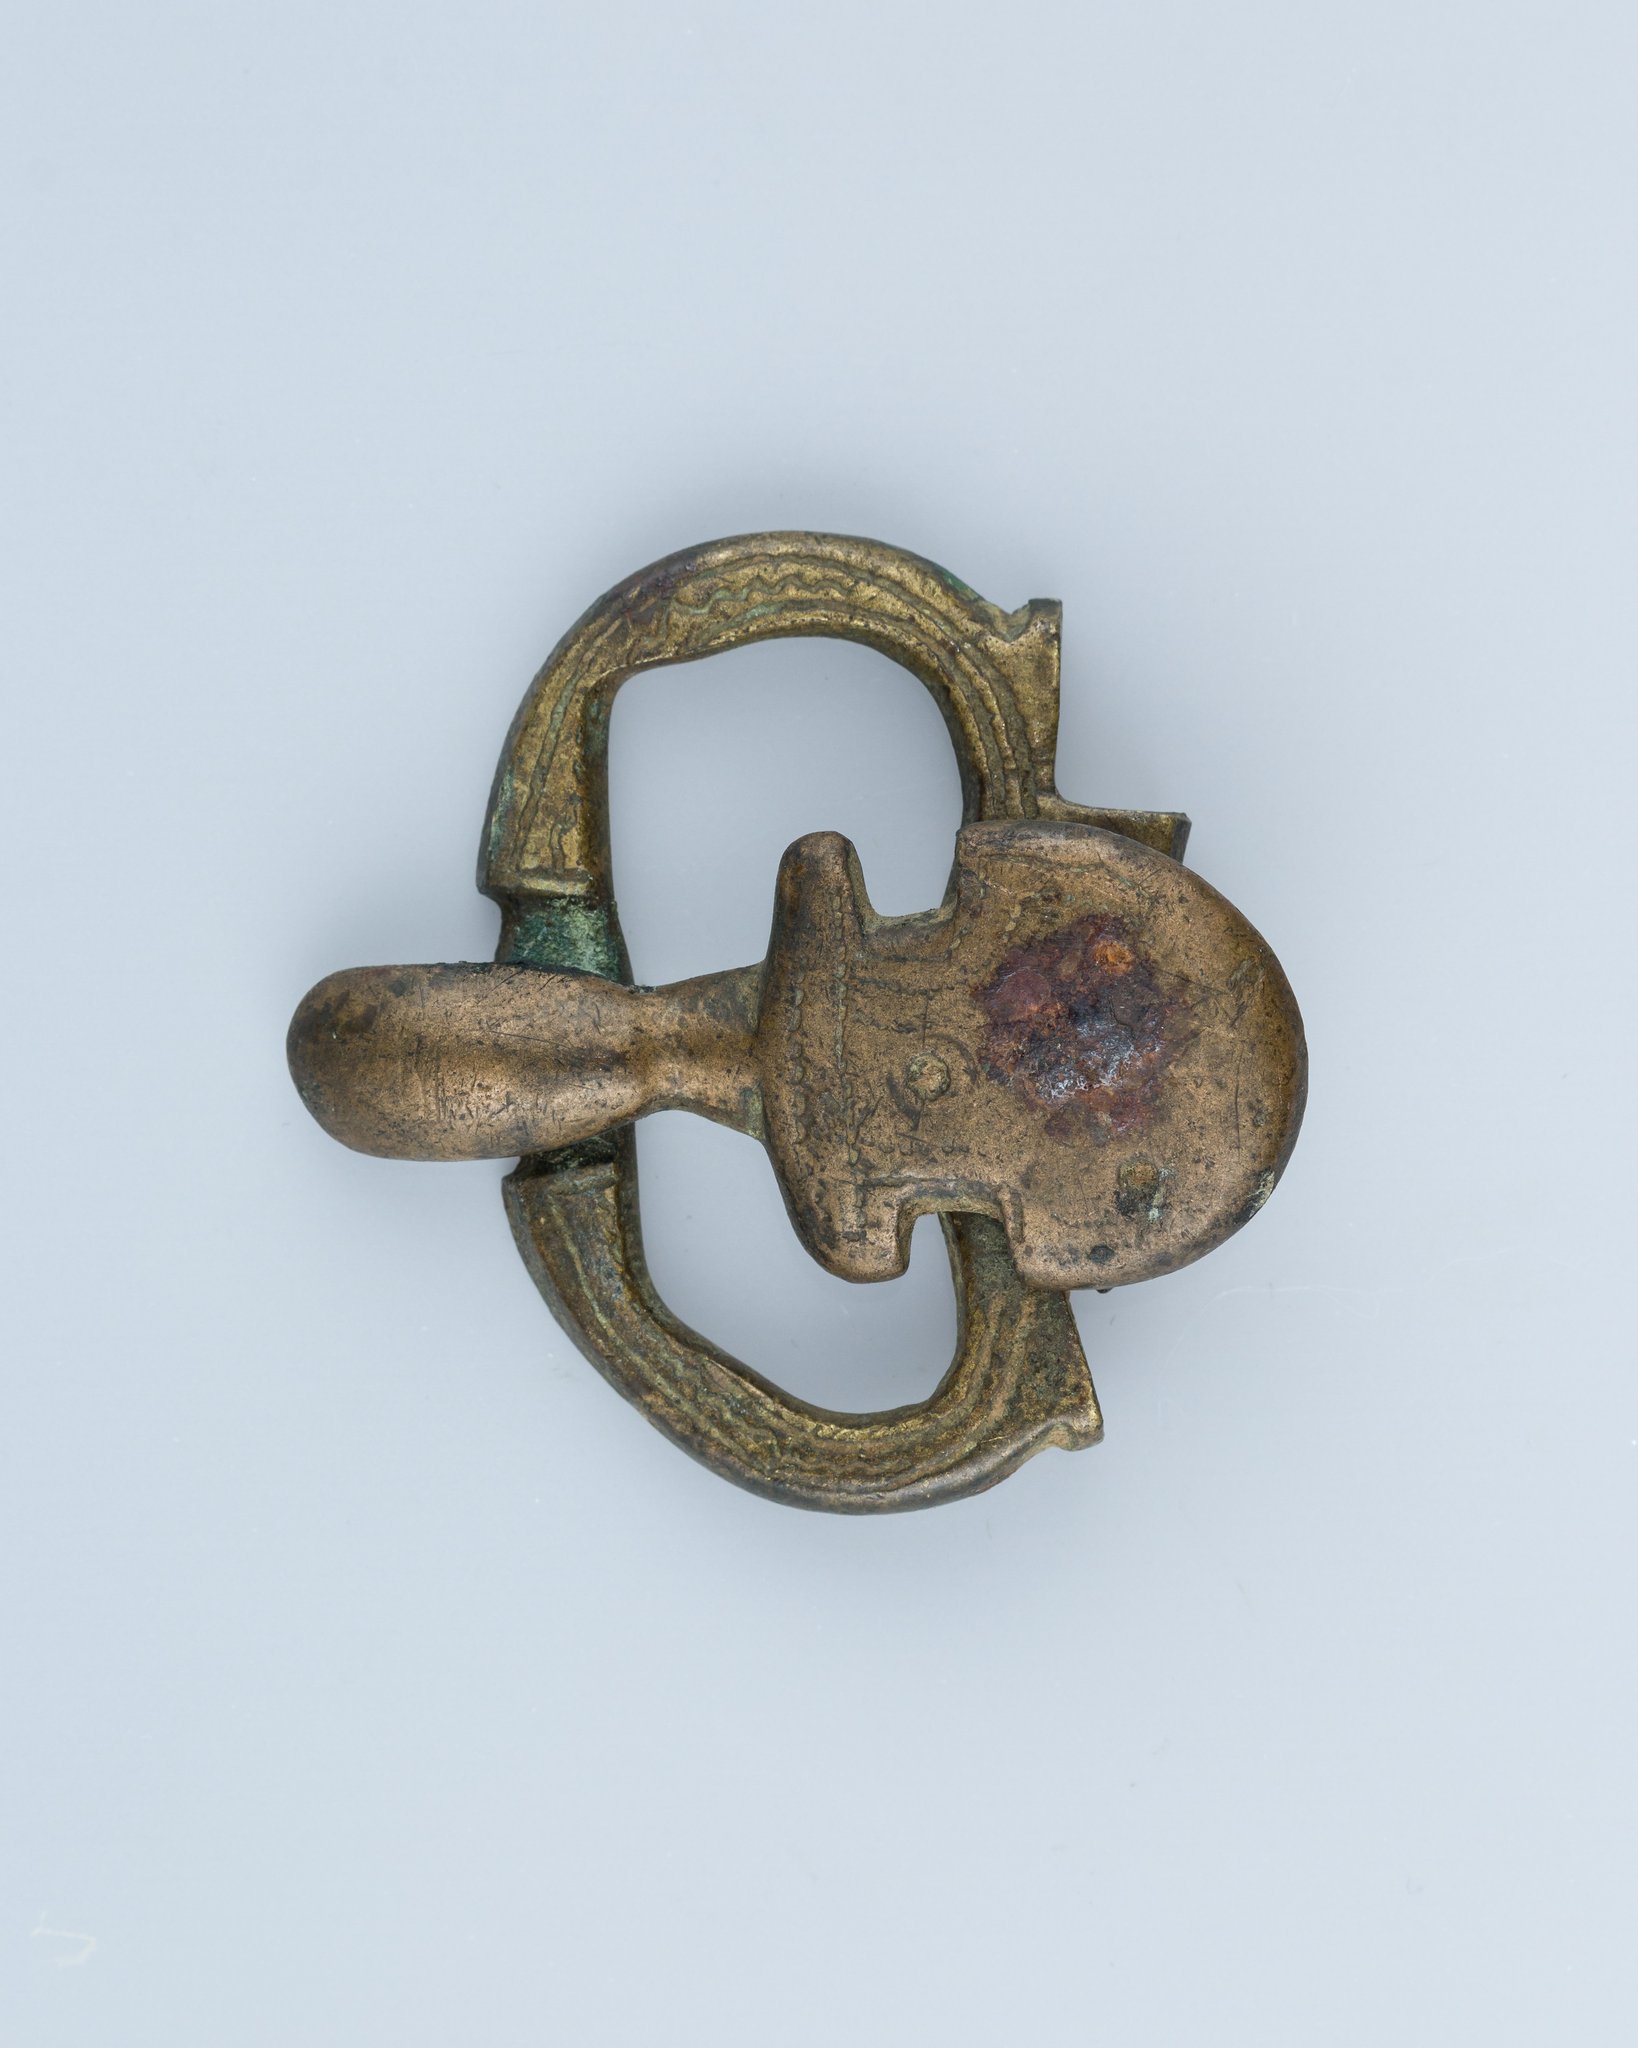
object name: buckle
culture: gallo-roman or merovingian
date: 401-600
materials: brass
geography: france